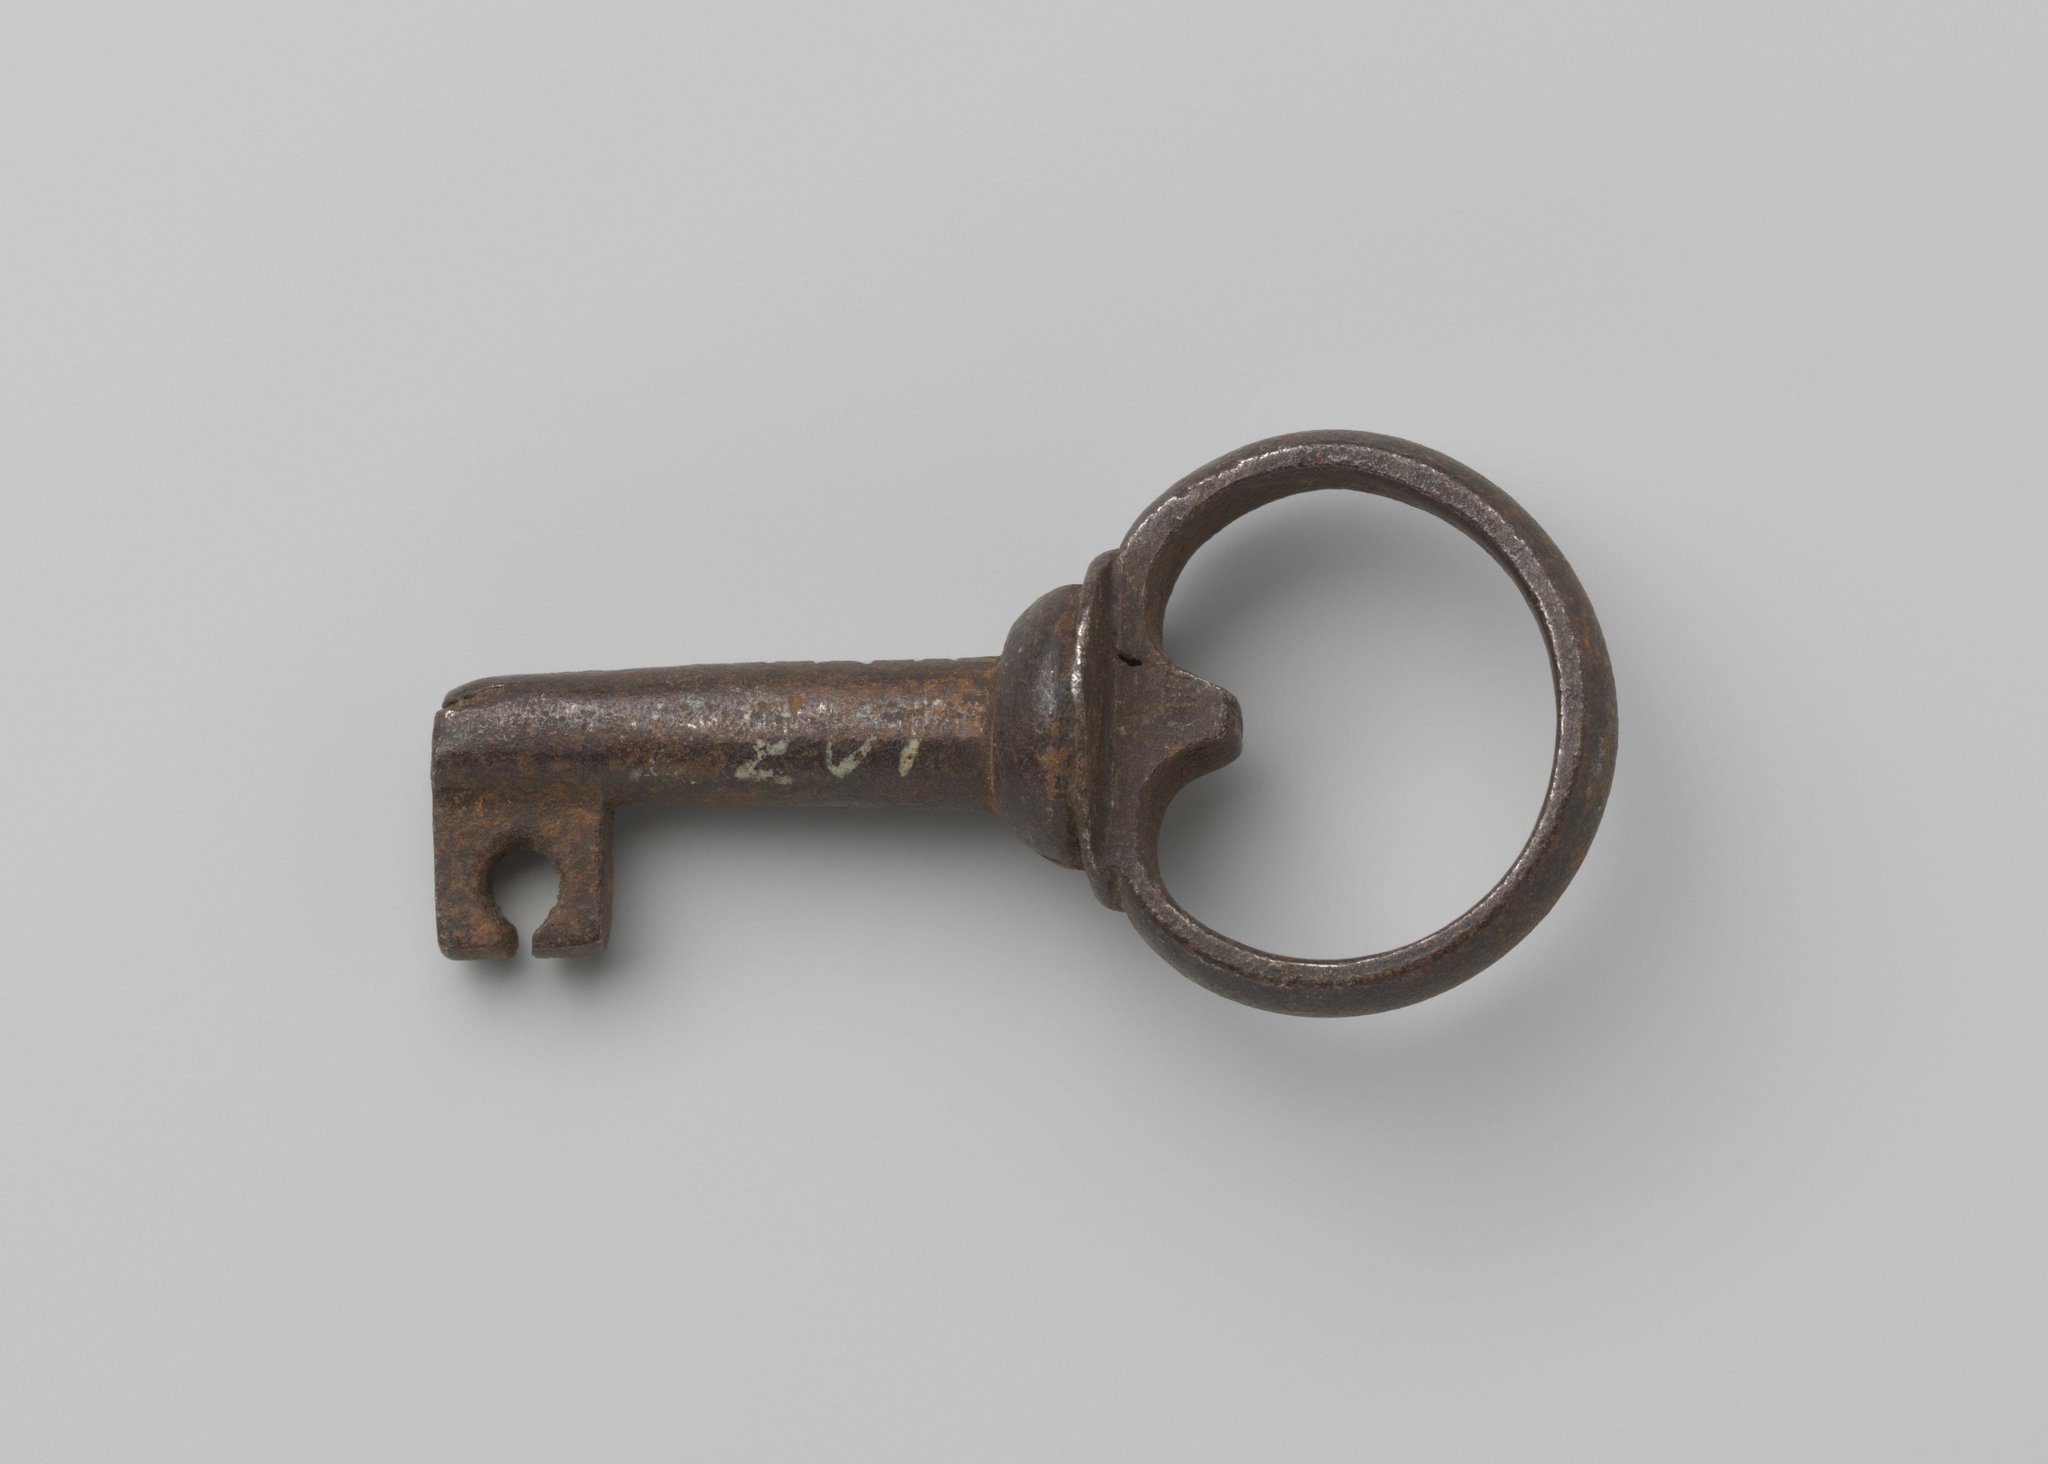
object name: key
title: Sleutel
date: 1400-1950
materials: iron